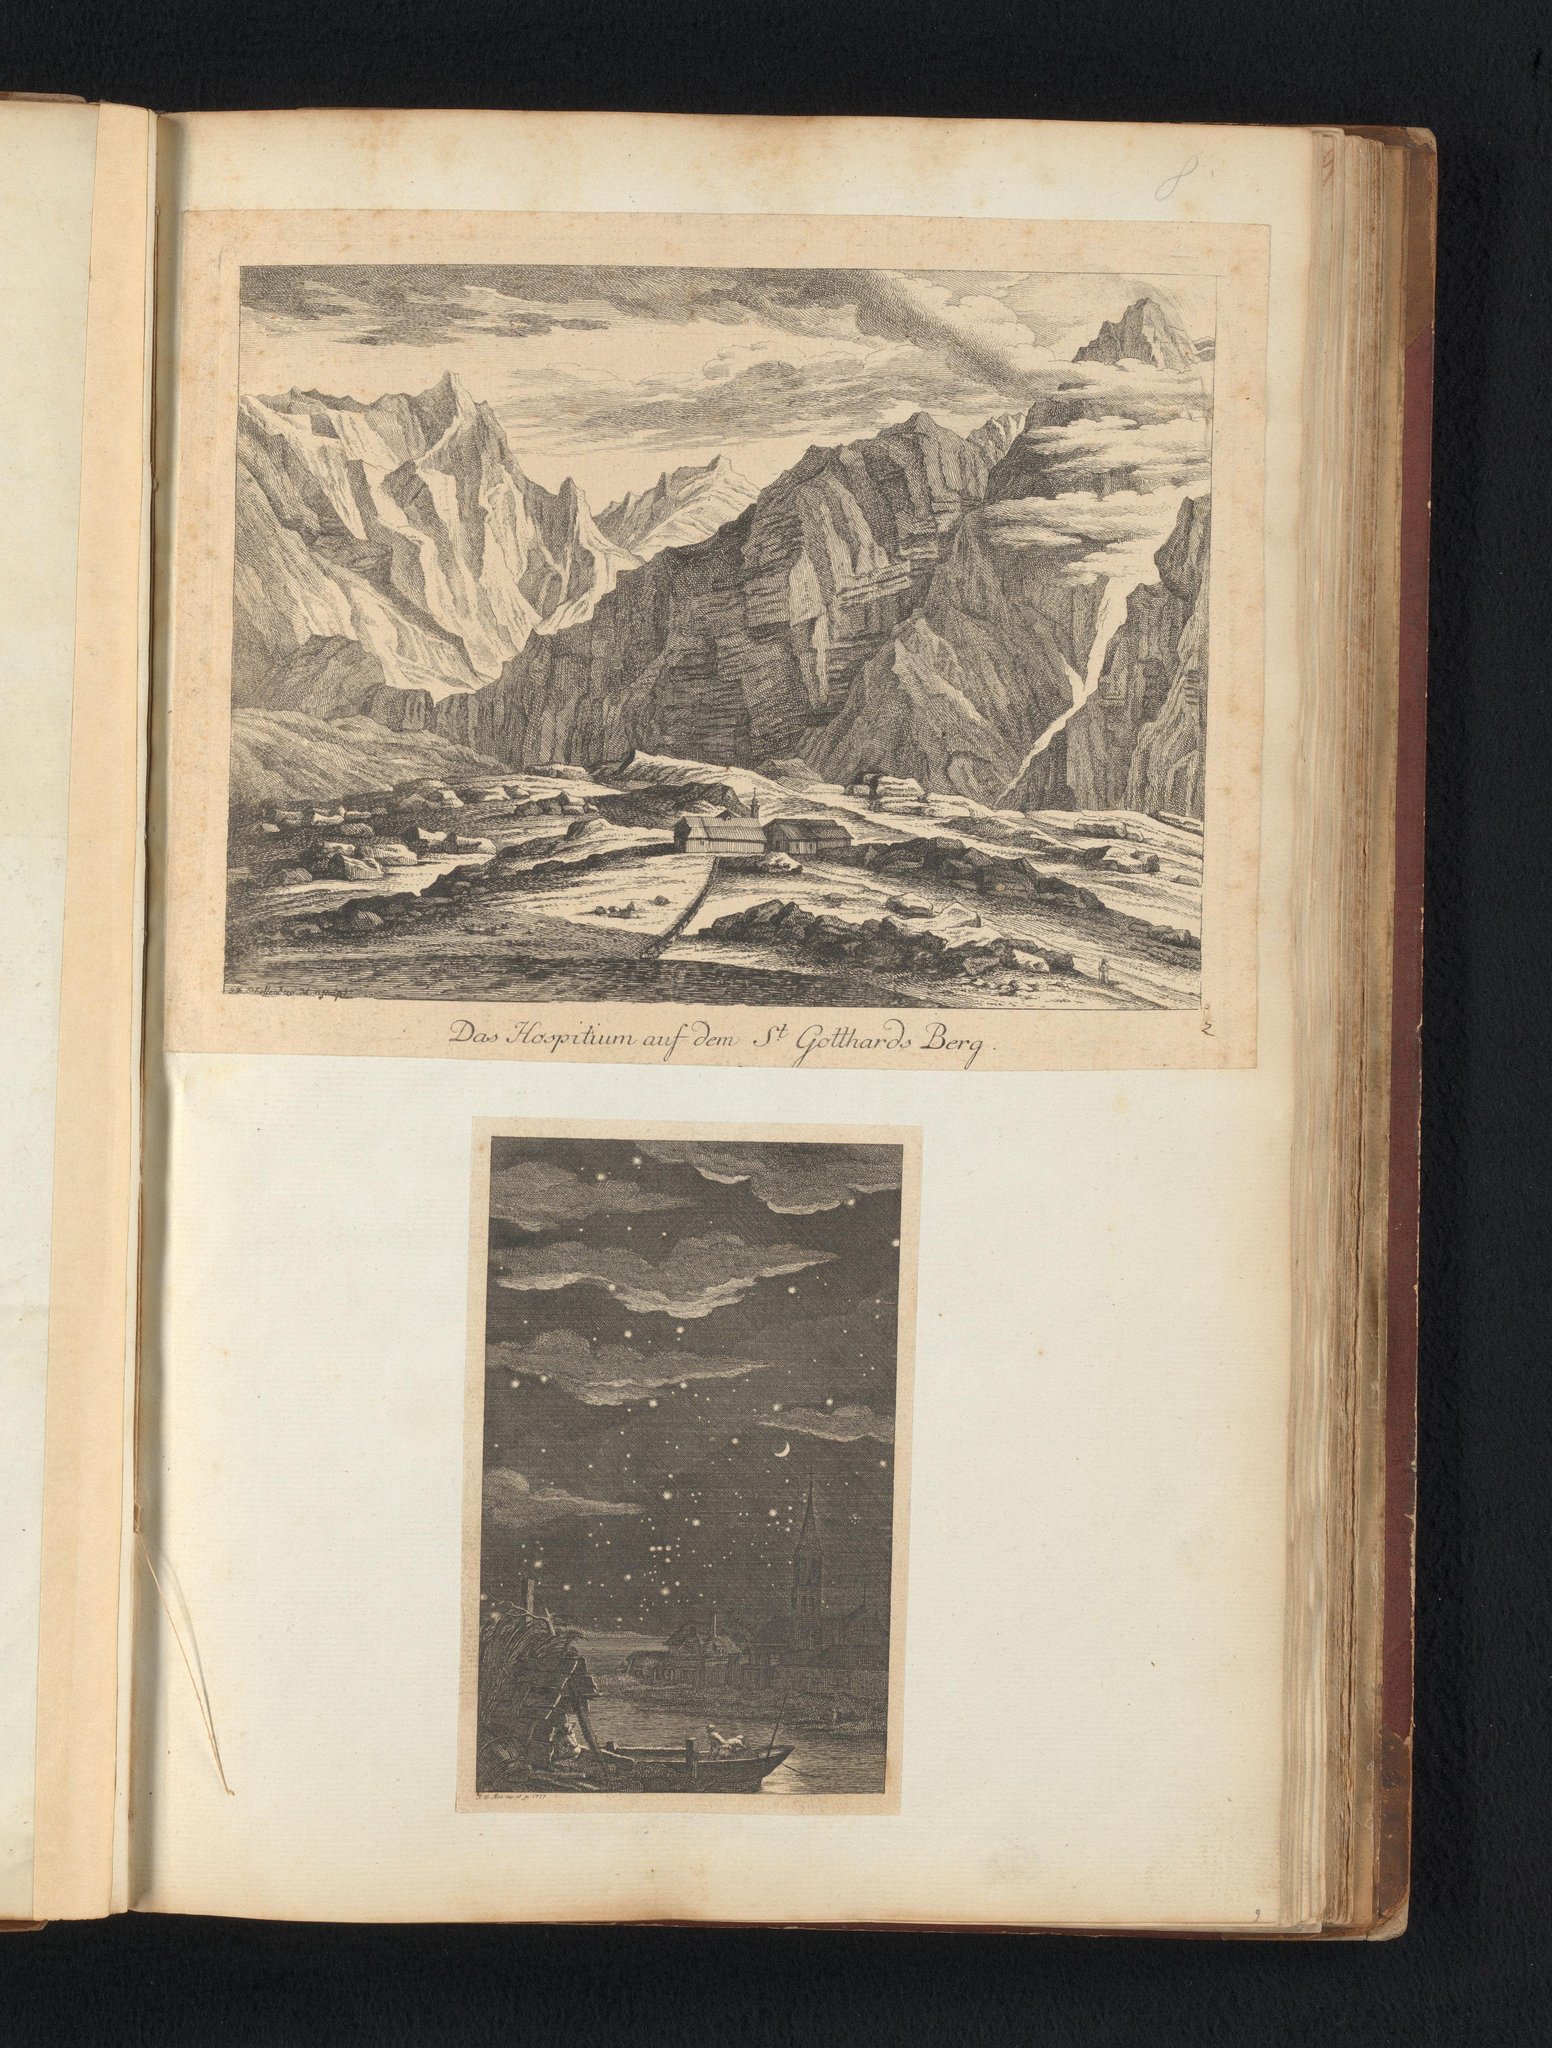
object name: print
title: Berglandschap en sterrenhemel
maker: johann wilhelm meil (der jüngere)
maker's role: print maker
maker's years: 1733-1805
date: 1750-1816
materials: paper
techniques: engraving, etching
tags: stars, rocks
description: Berglandschap bij de Sint-Gotthard en een sterrenhemel. Onderdeel van het tweede van twee albums met ingeplakte prenten en tekeningen te dienen als tekenvoorbeelden.